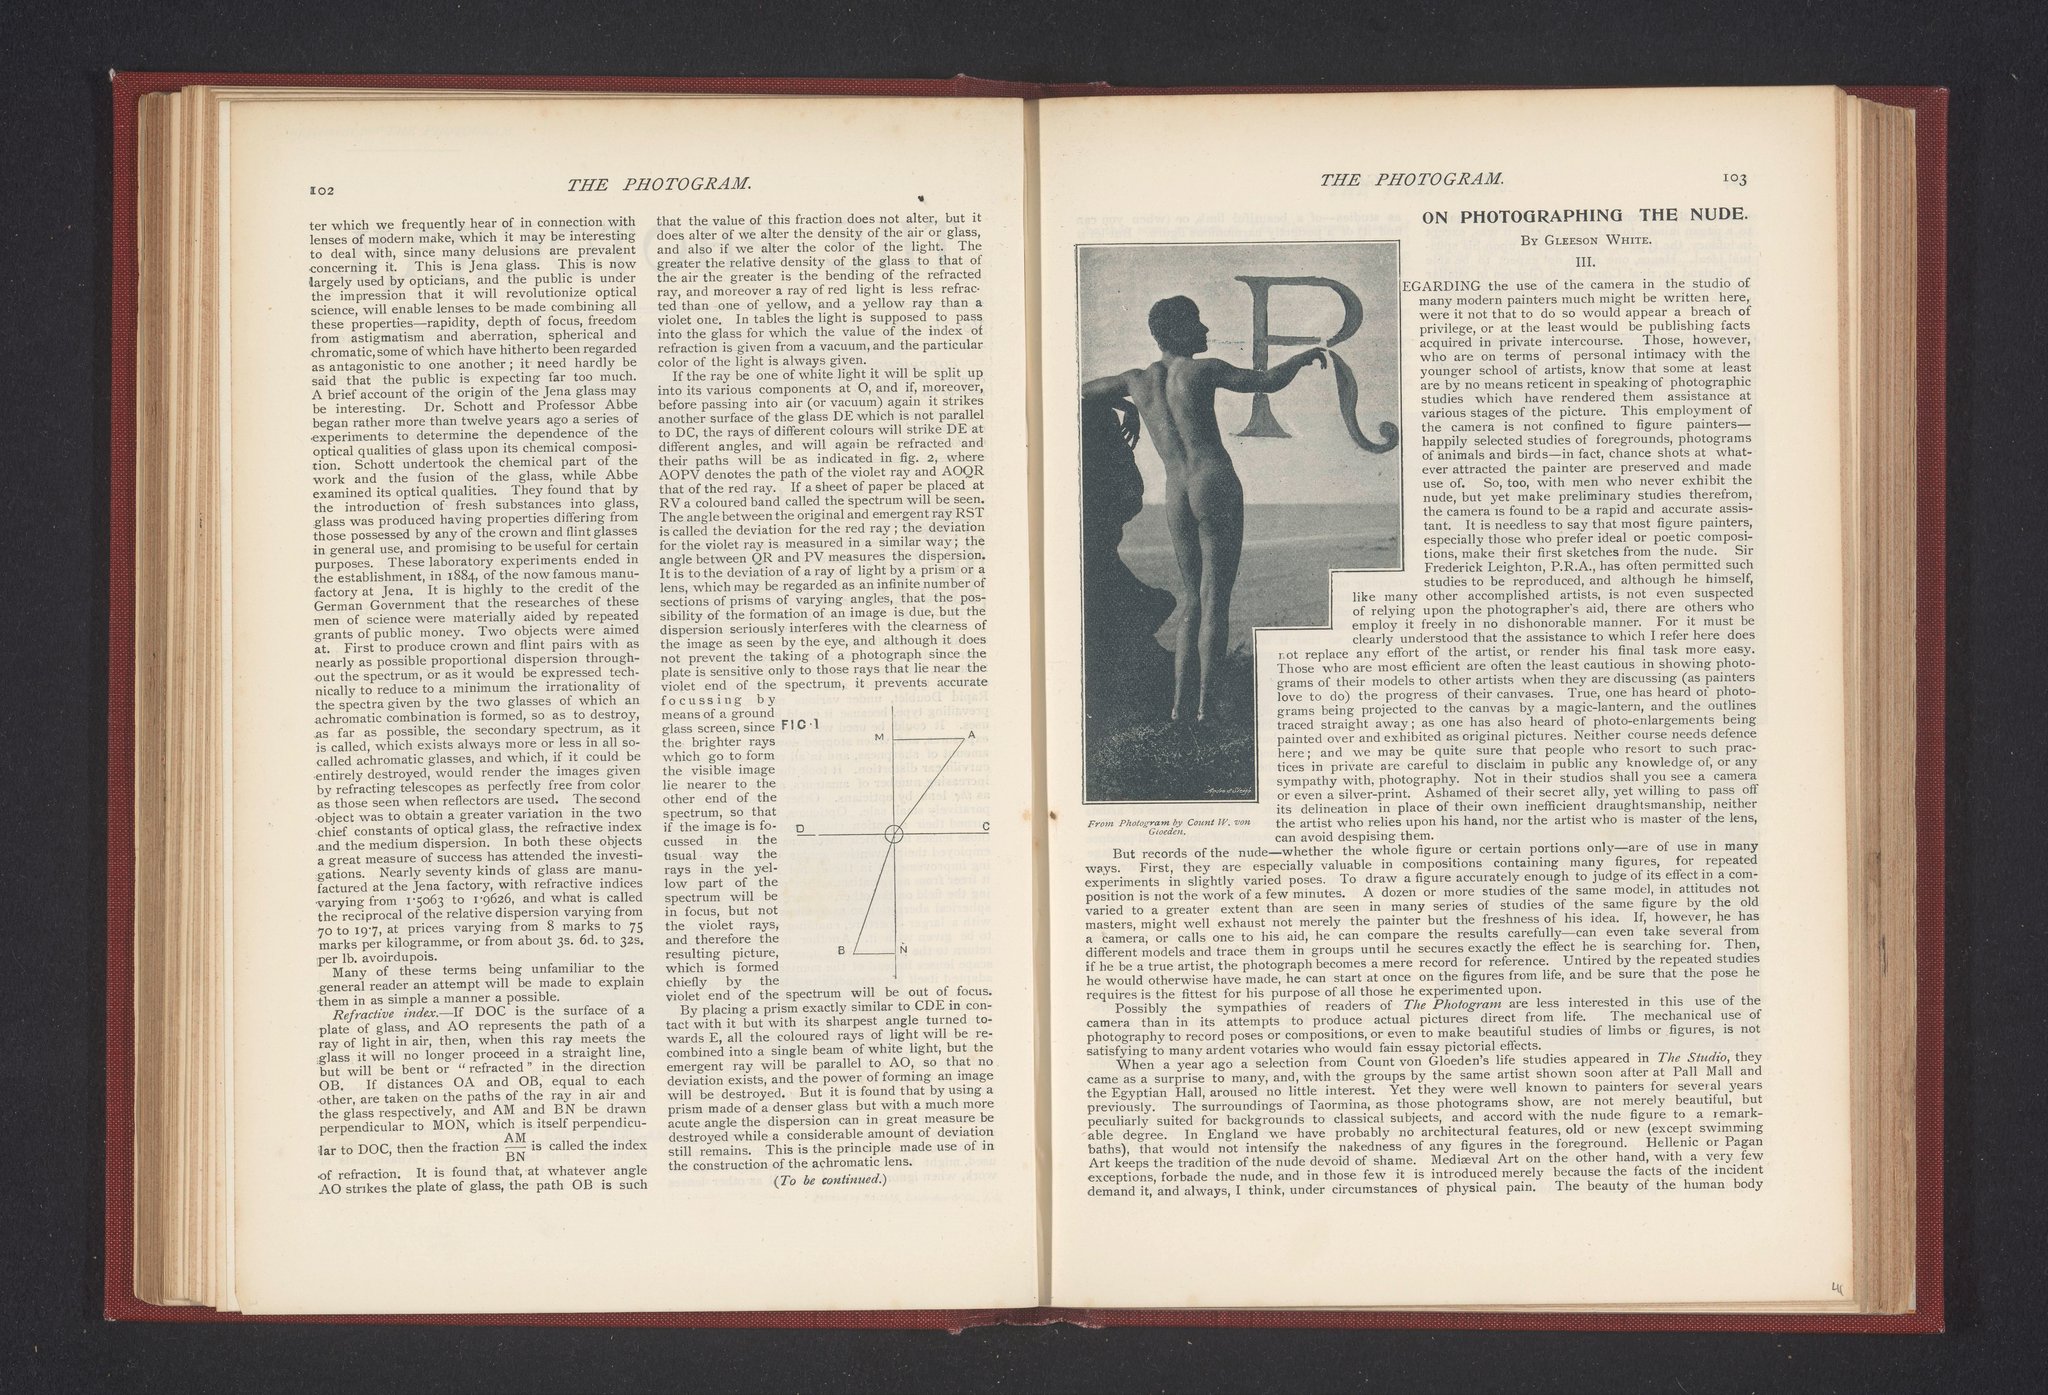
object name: page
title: Naakte jongen bij zee, op de rug gezien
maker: wilhelm von gloeden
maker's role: fotograaf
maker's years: 1856-1931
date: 1889-1894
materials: paper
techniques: autotype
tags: the (nude) human figure; 'corpo humano' (ripa), sea